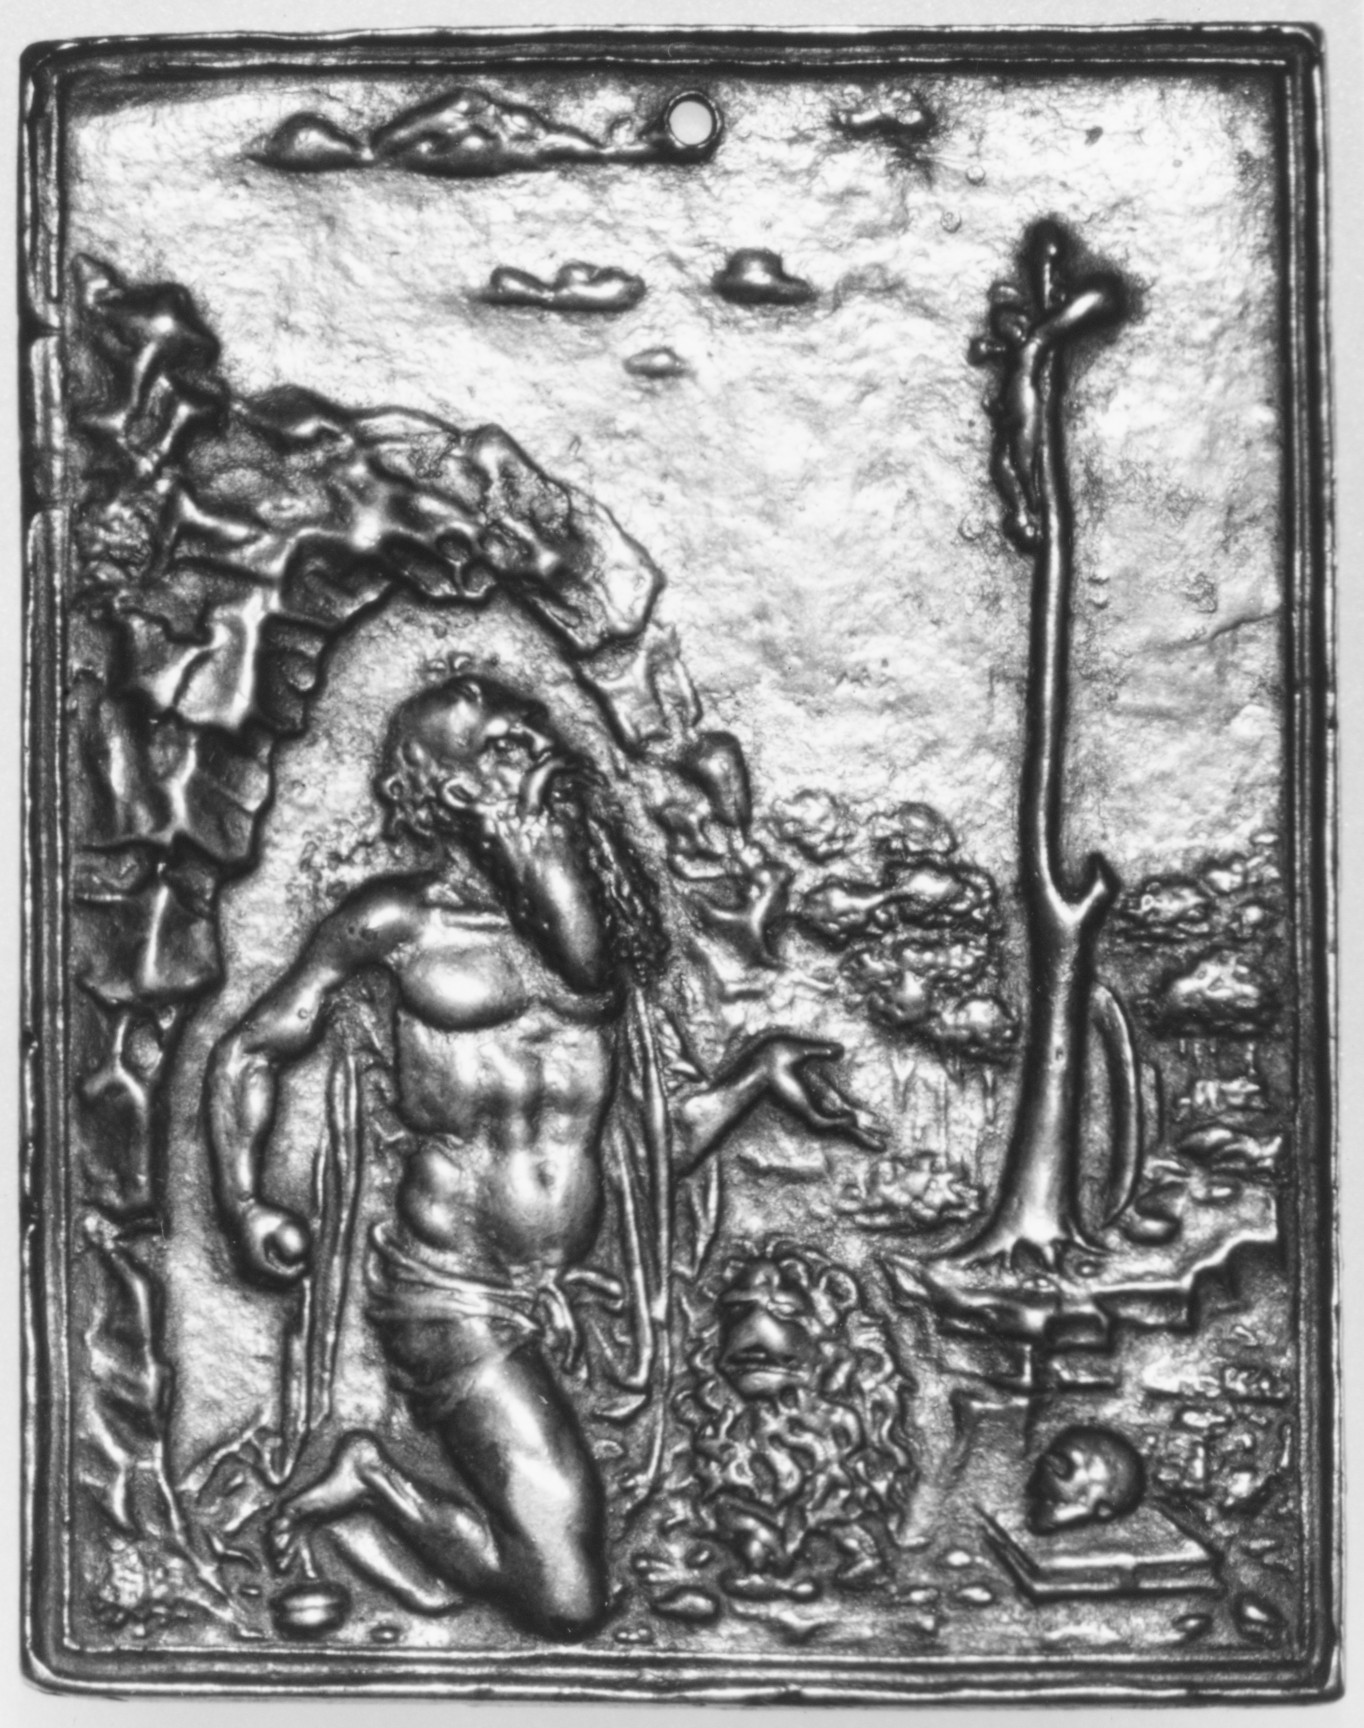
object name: plaquette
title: St. Jerome in the Desert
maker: moderno (galeazzo mondella)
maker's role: artist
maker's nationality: italian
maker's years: 1467-1528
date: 1501-1533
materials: bronze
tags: saint jerome